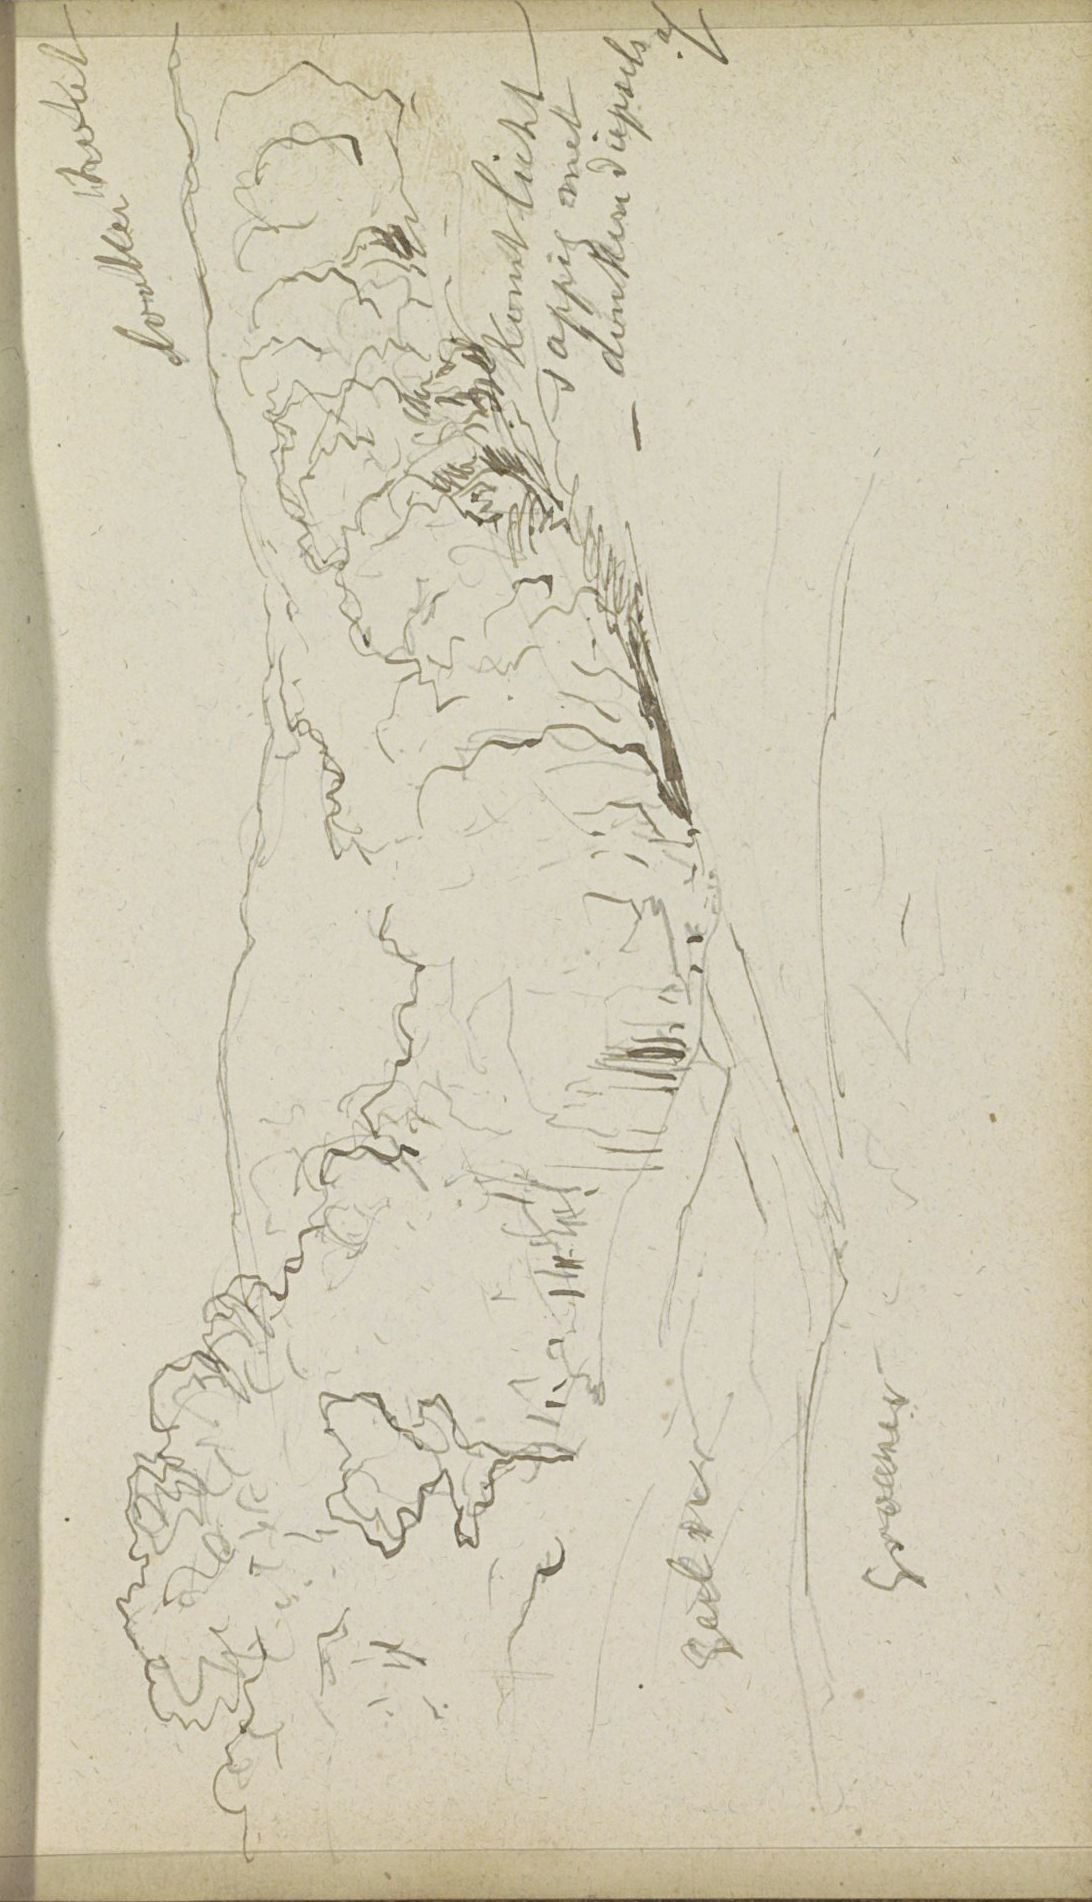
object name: sketchbook leaf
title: Bos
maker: johannes tavenraat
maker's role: draughtsman, painter, print maker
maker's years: 1809-1881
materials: ink, paper, pencil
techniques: pen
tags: forest, wood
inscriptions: kleurnotitie, handgeschreven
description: Blad 19 recto uit een schetsboek met 88 bladen.